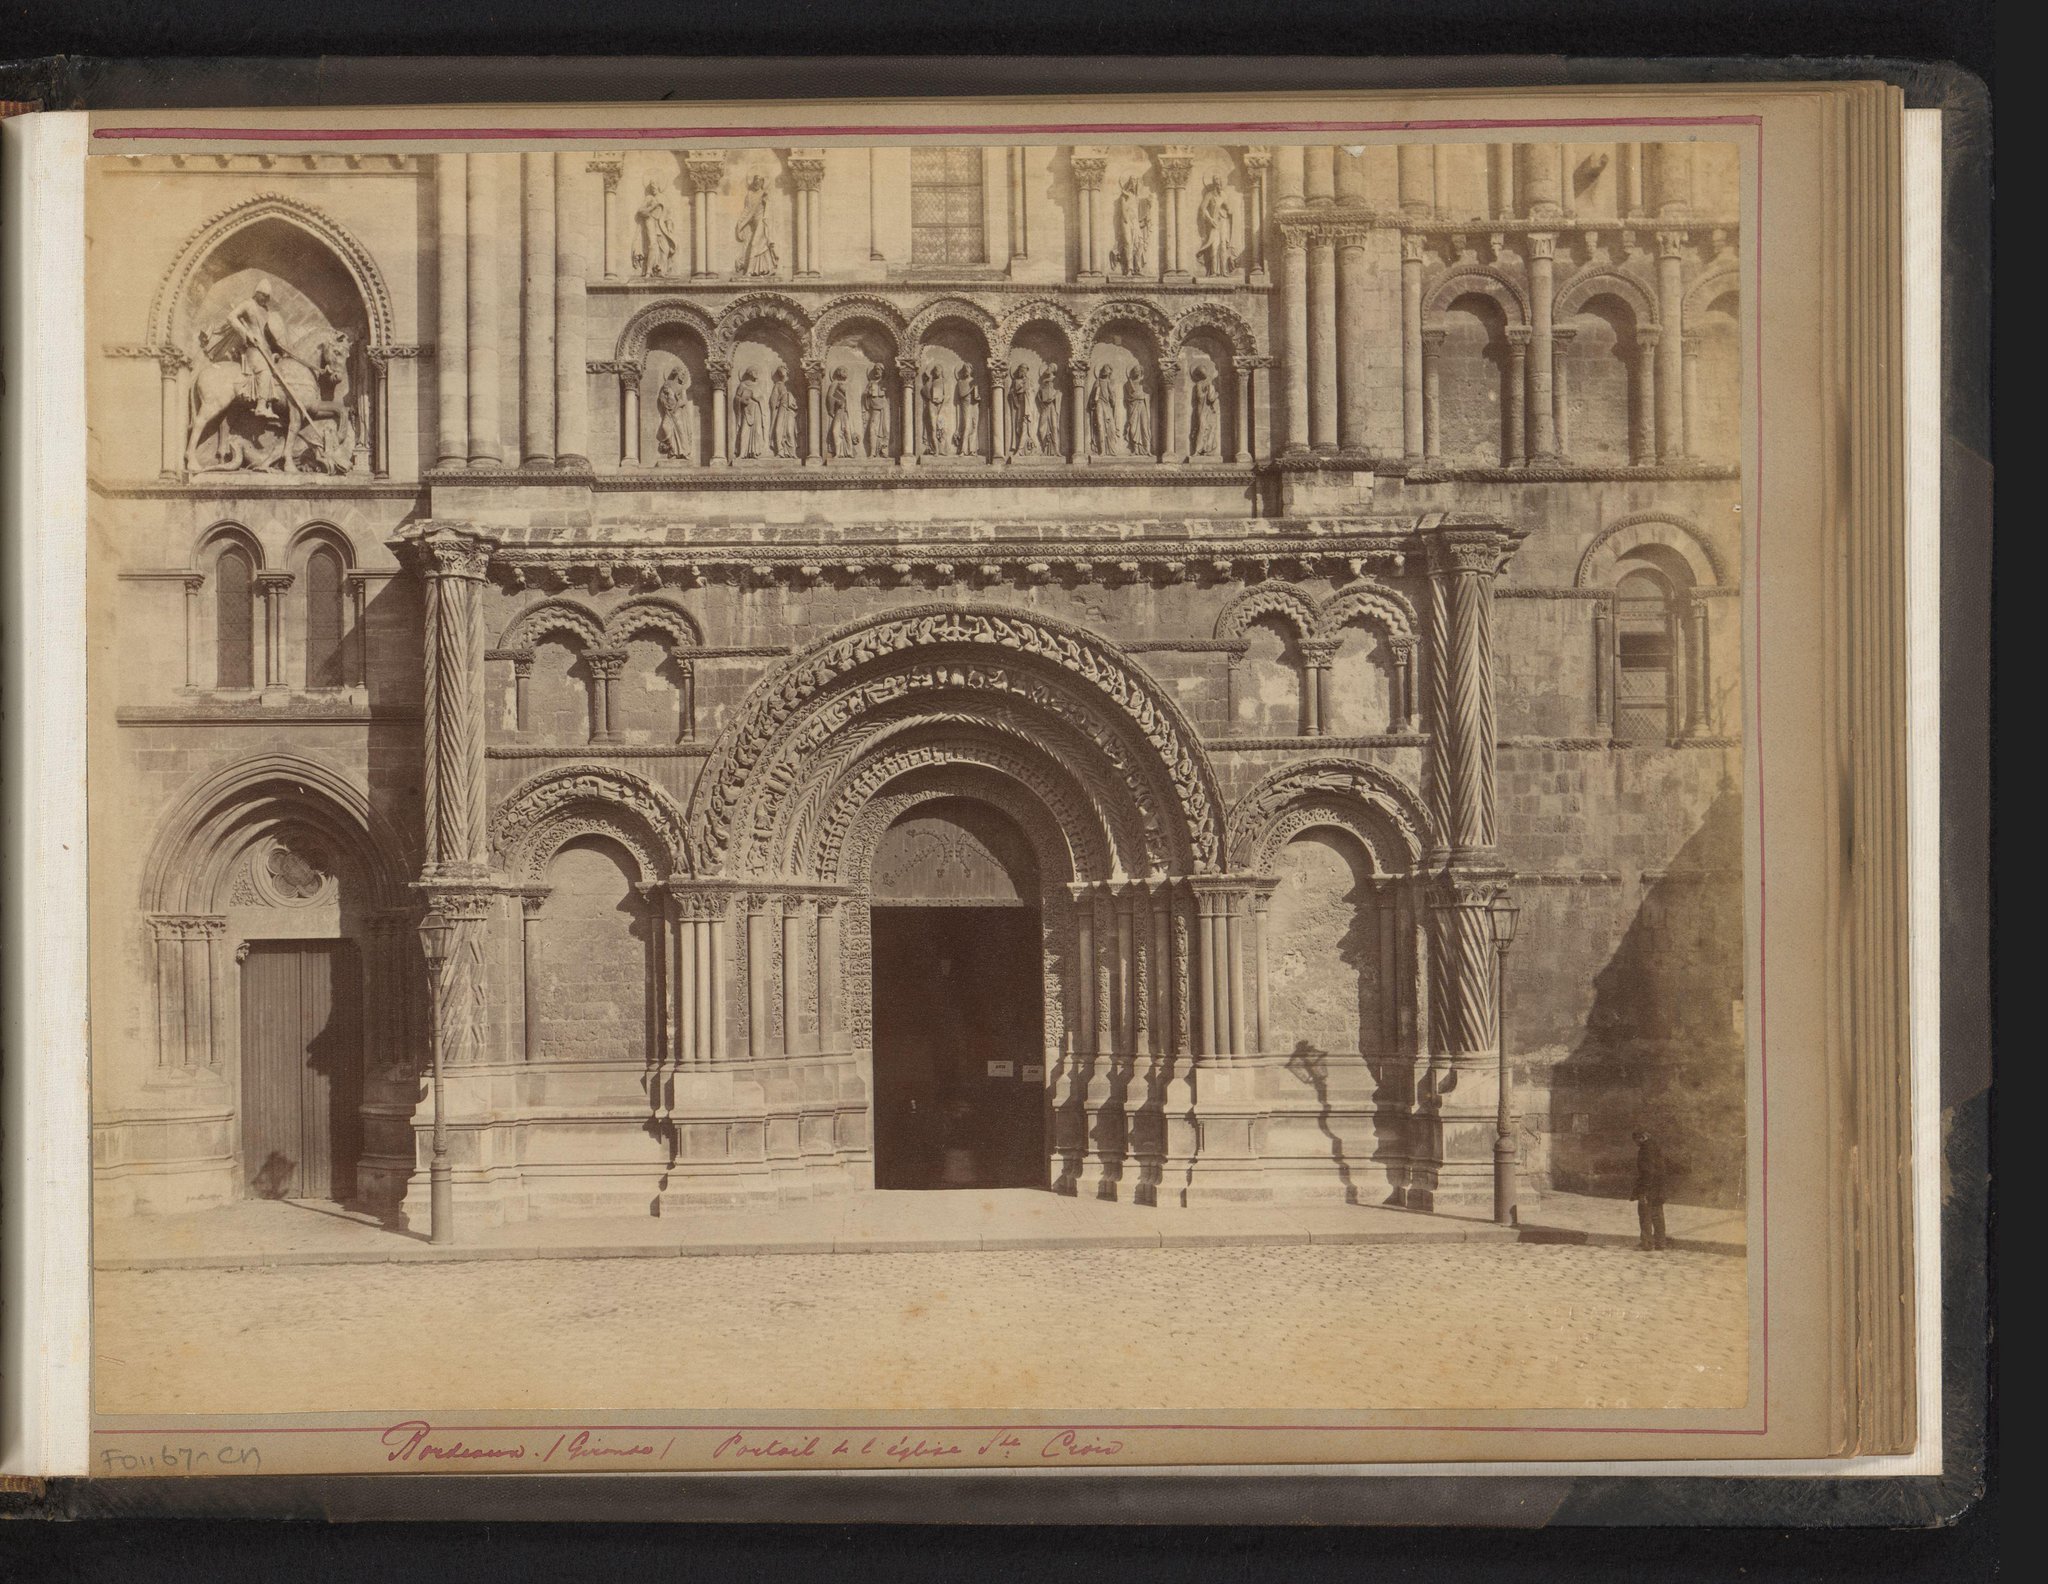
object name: album leaf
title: Portaal van de Kerk van het Heilige Kruis te Bordeaux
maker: Anonymous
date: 1880-1910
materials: photographic support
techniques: albumen print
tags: parts of church exterior and annexes: portal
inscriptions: annotation: ‘Bordeaux Gironde/ Portail de l'église Ste Croix’